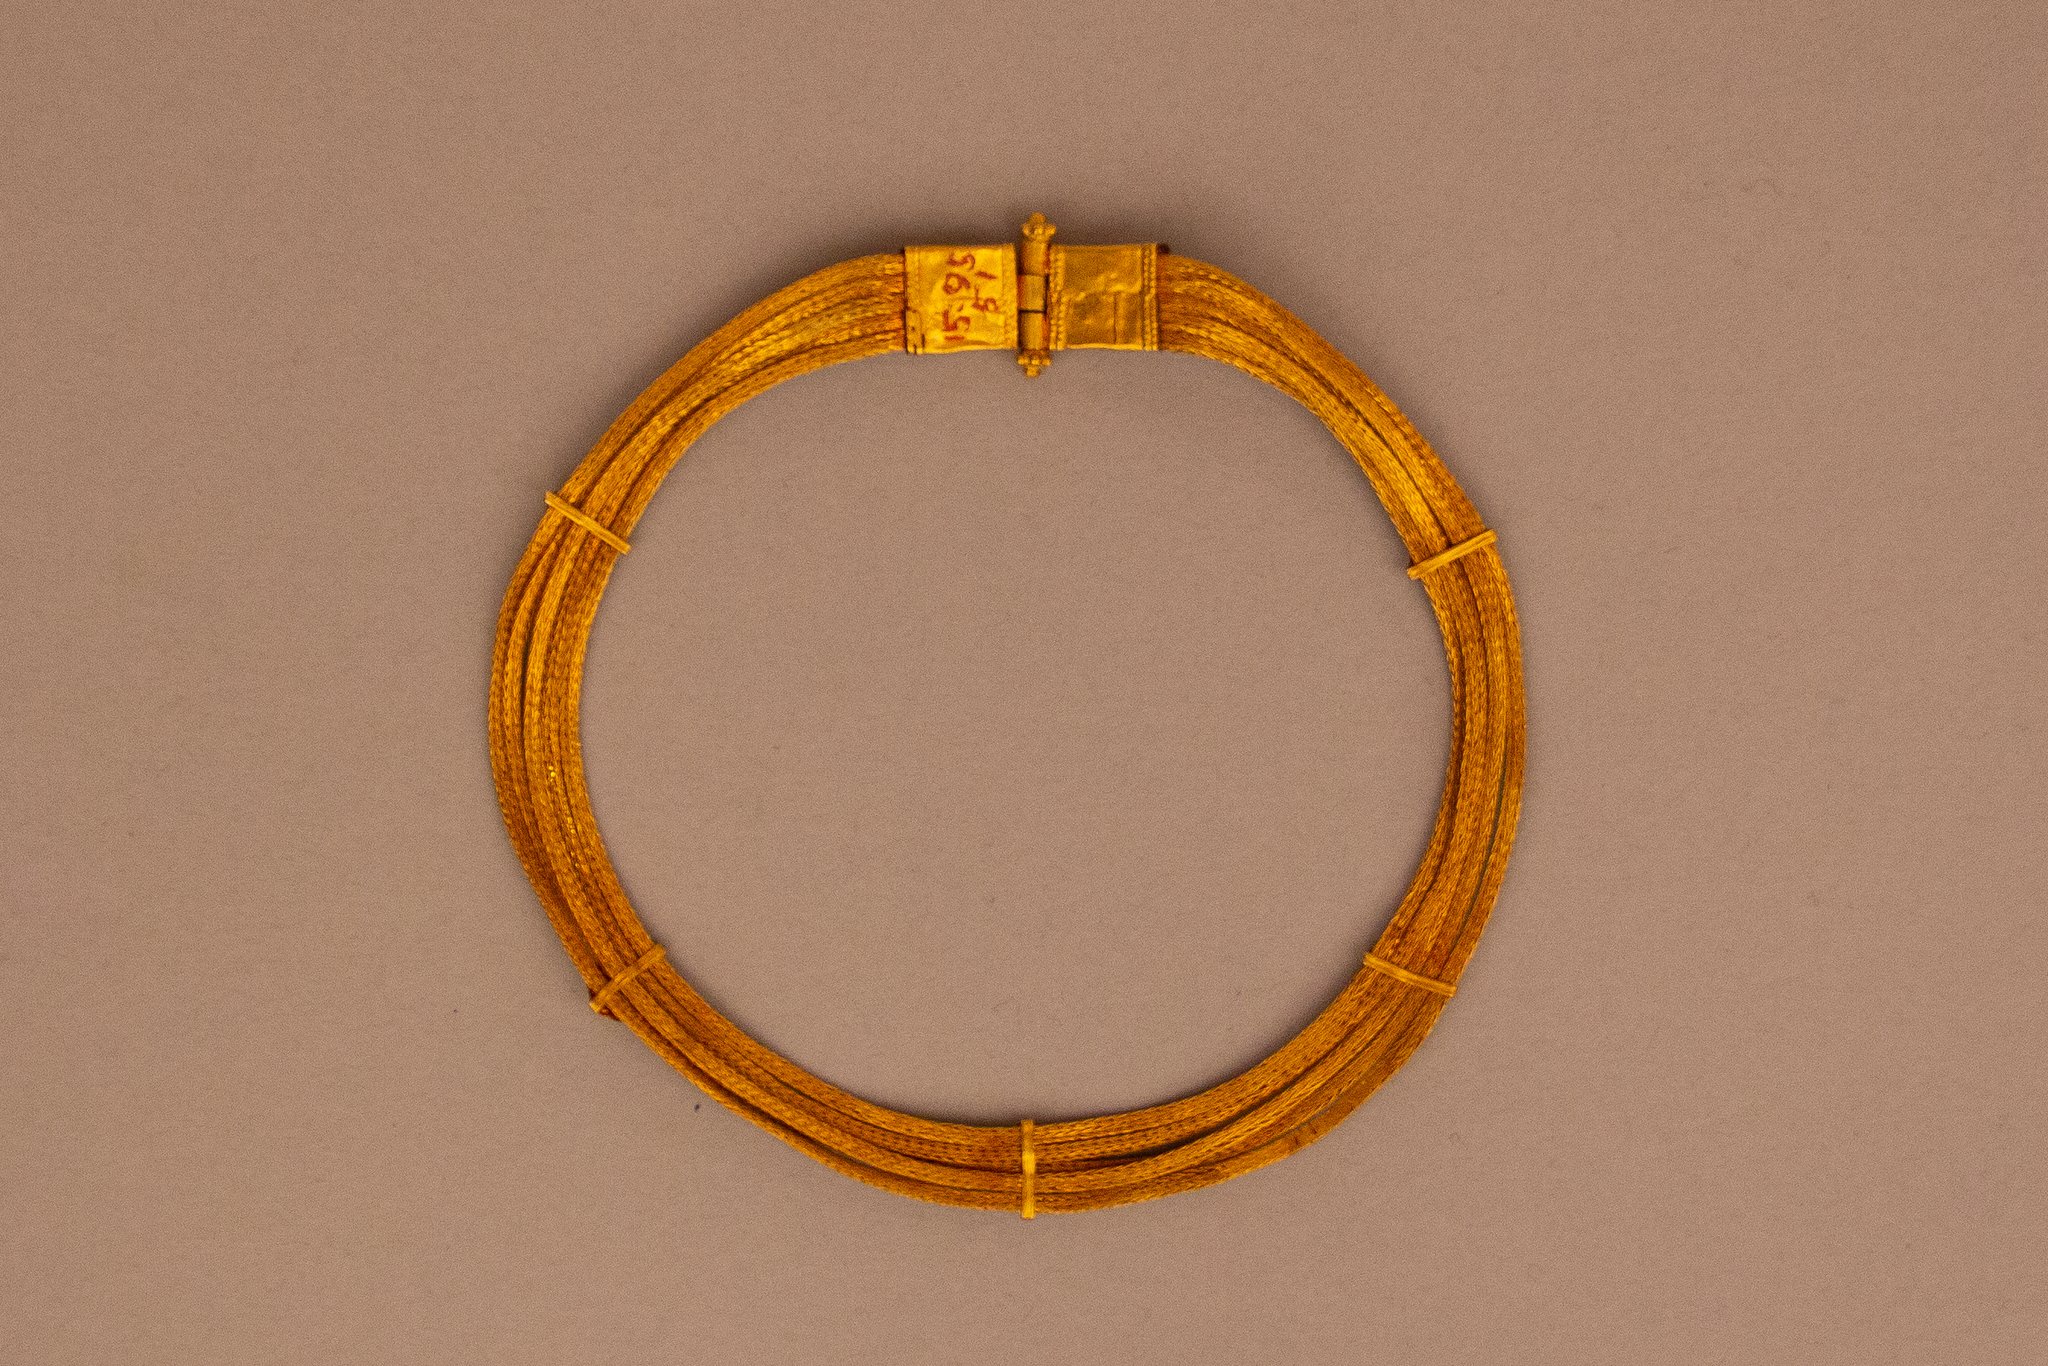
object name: necklet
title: Necklet (Musi)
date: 1701-1900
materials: gold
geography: india